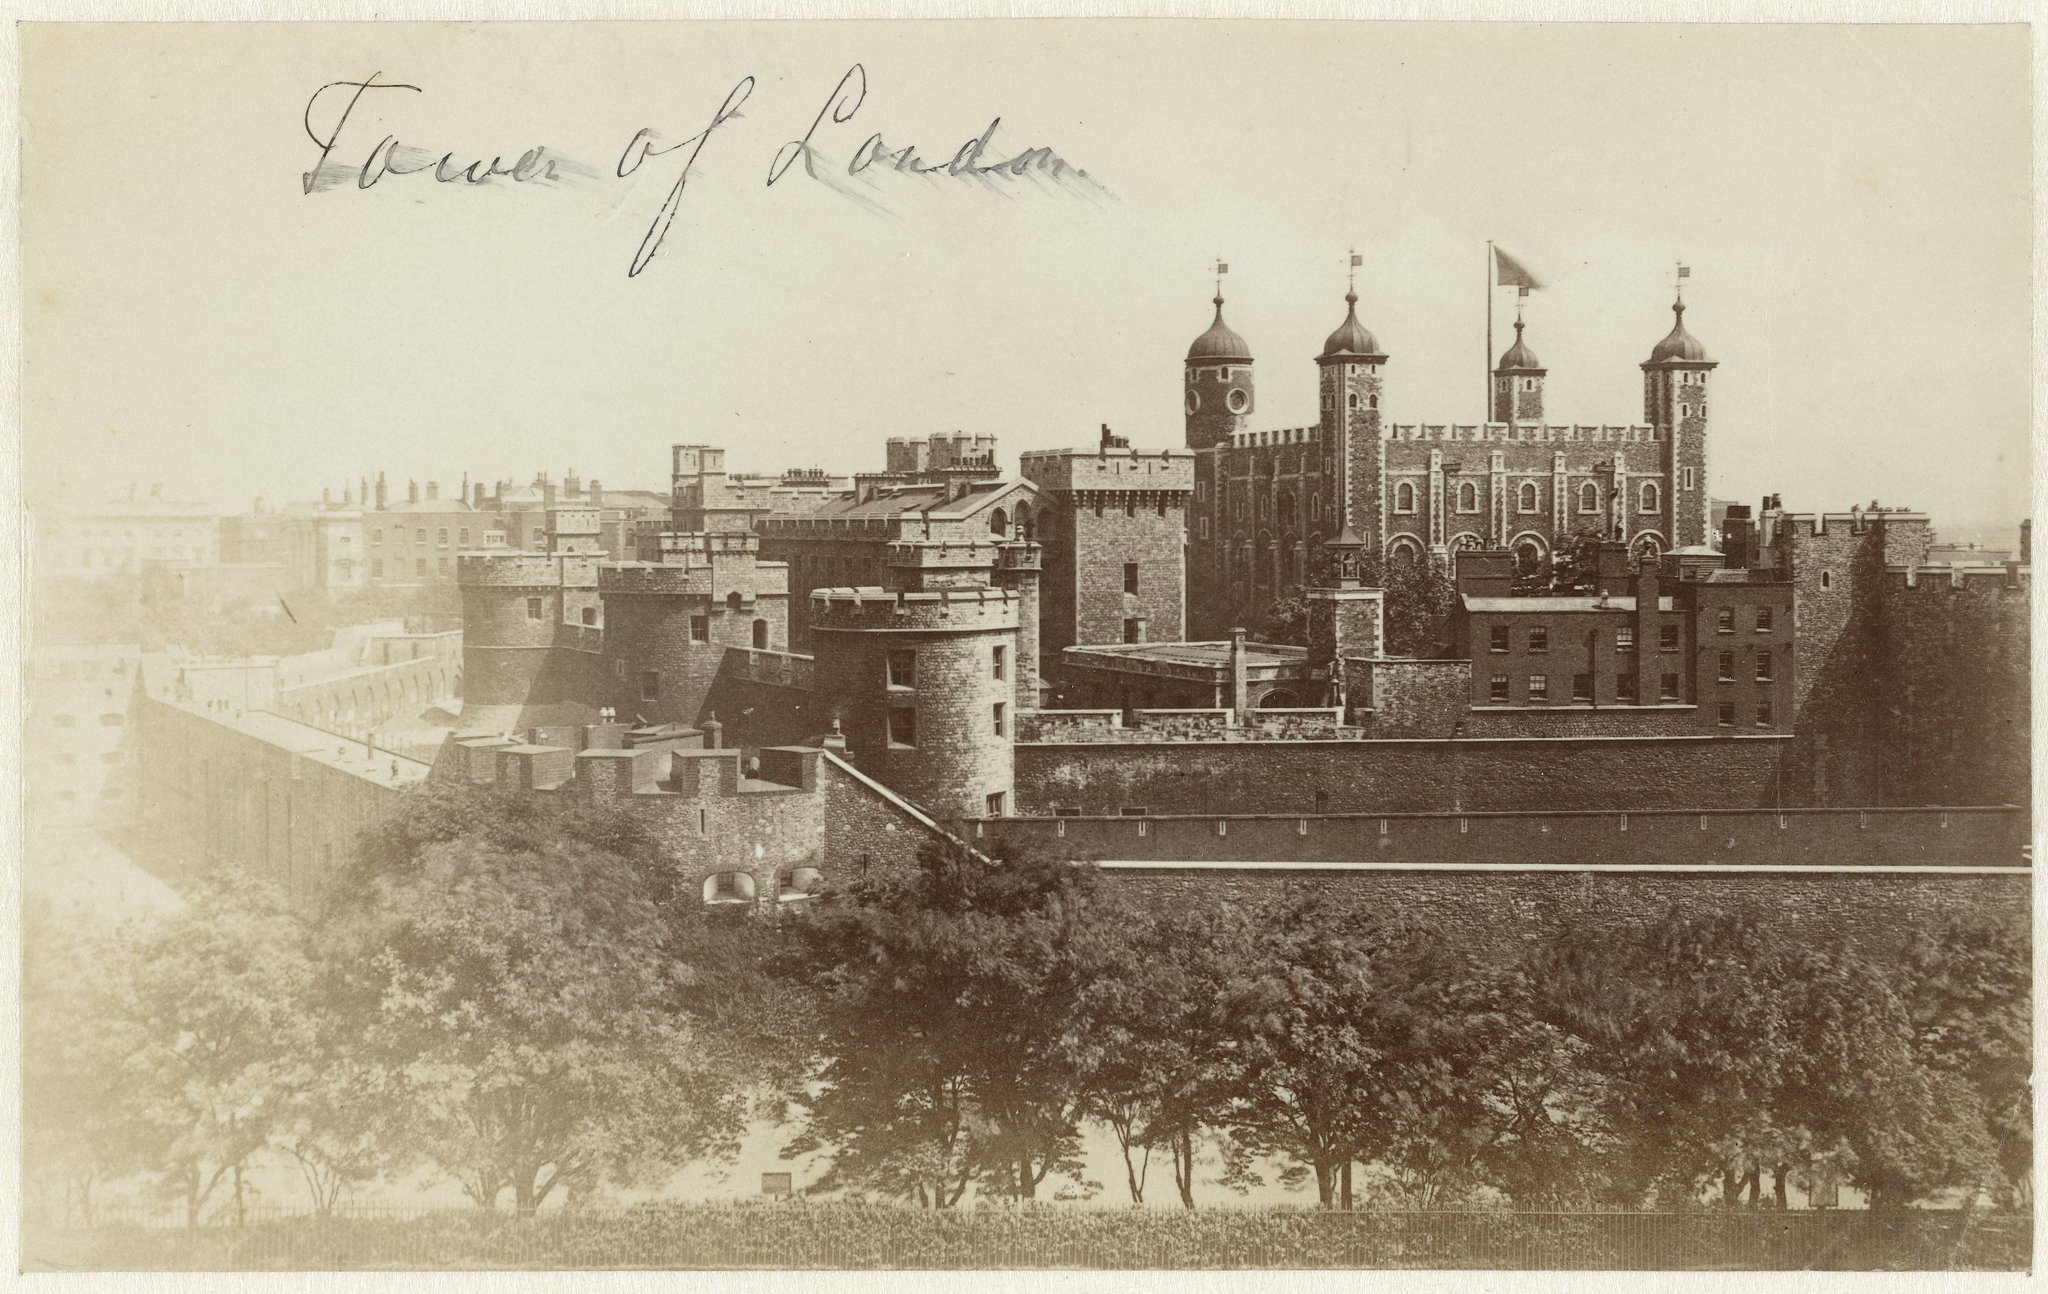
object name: photograph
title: Tower of London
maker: Anonymous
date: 1851-1900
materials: paper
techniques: albumen print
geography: london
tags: fortress